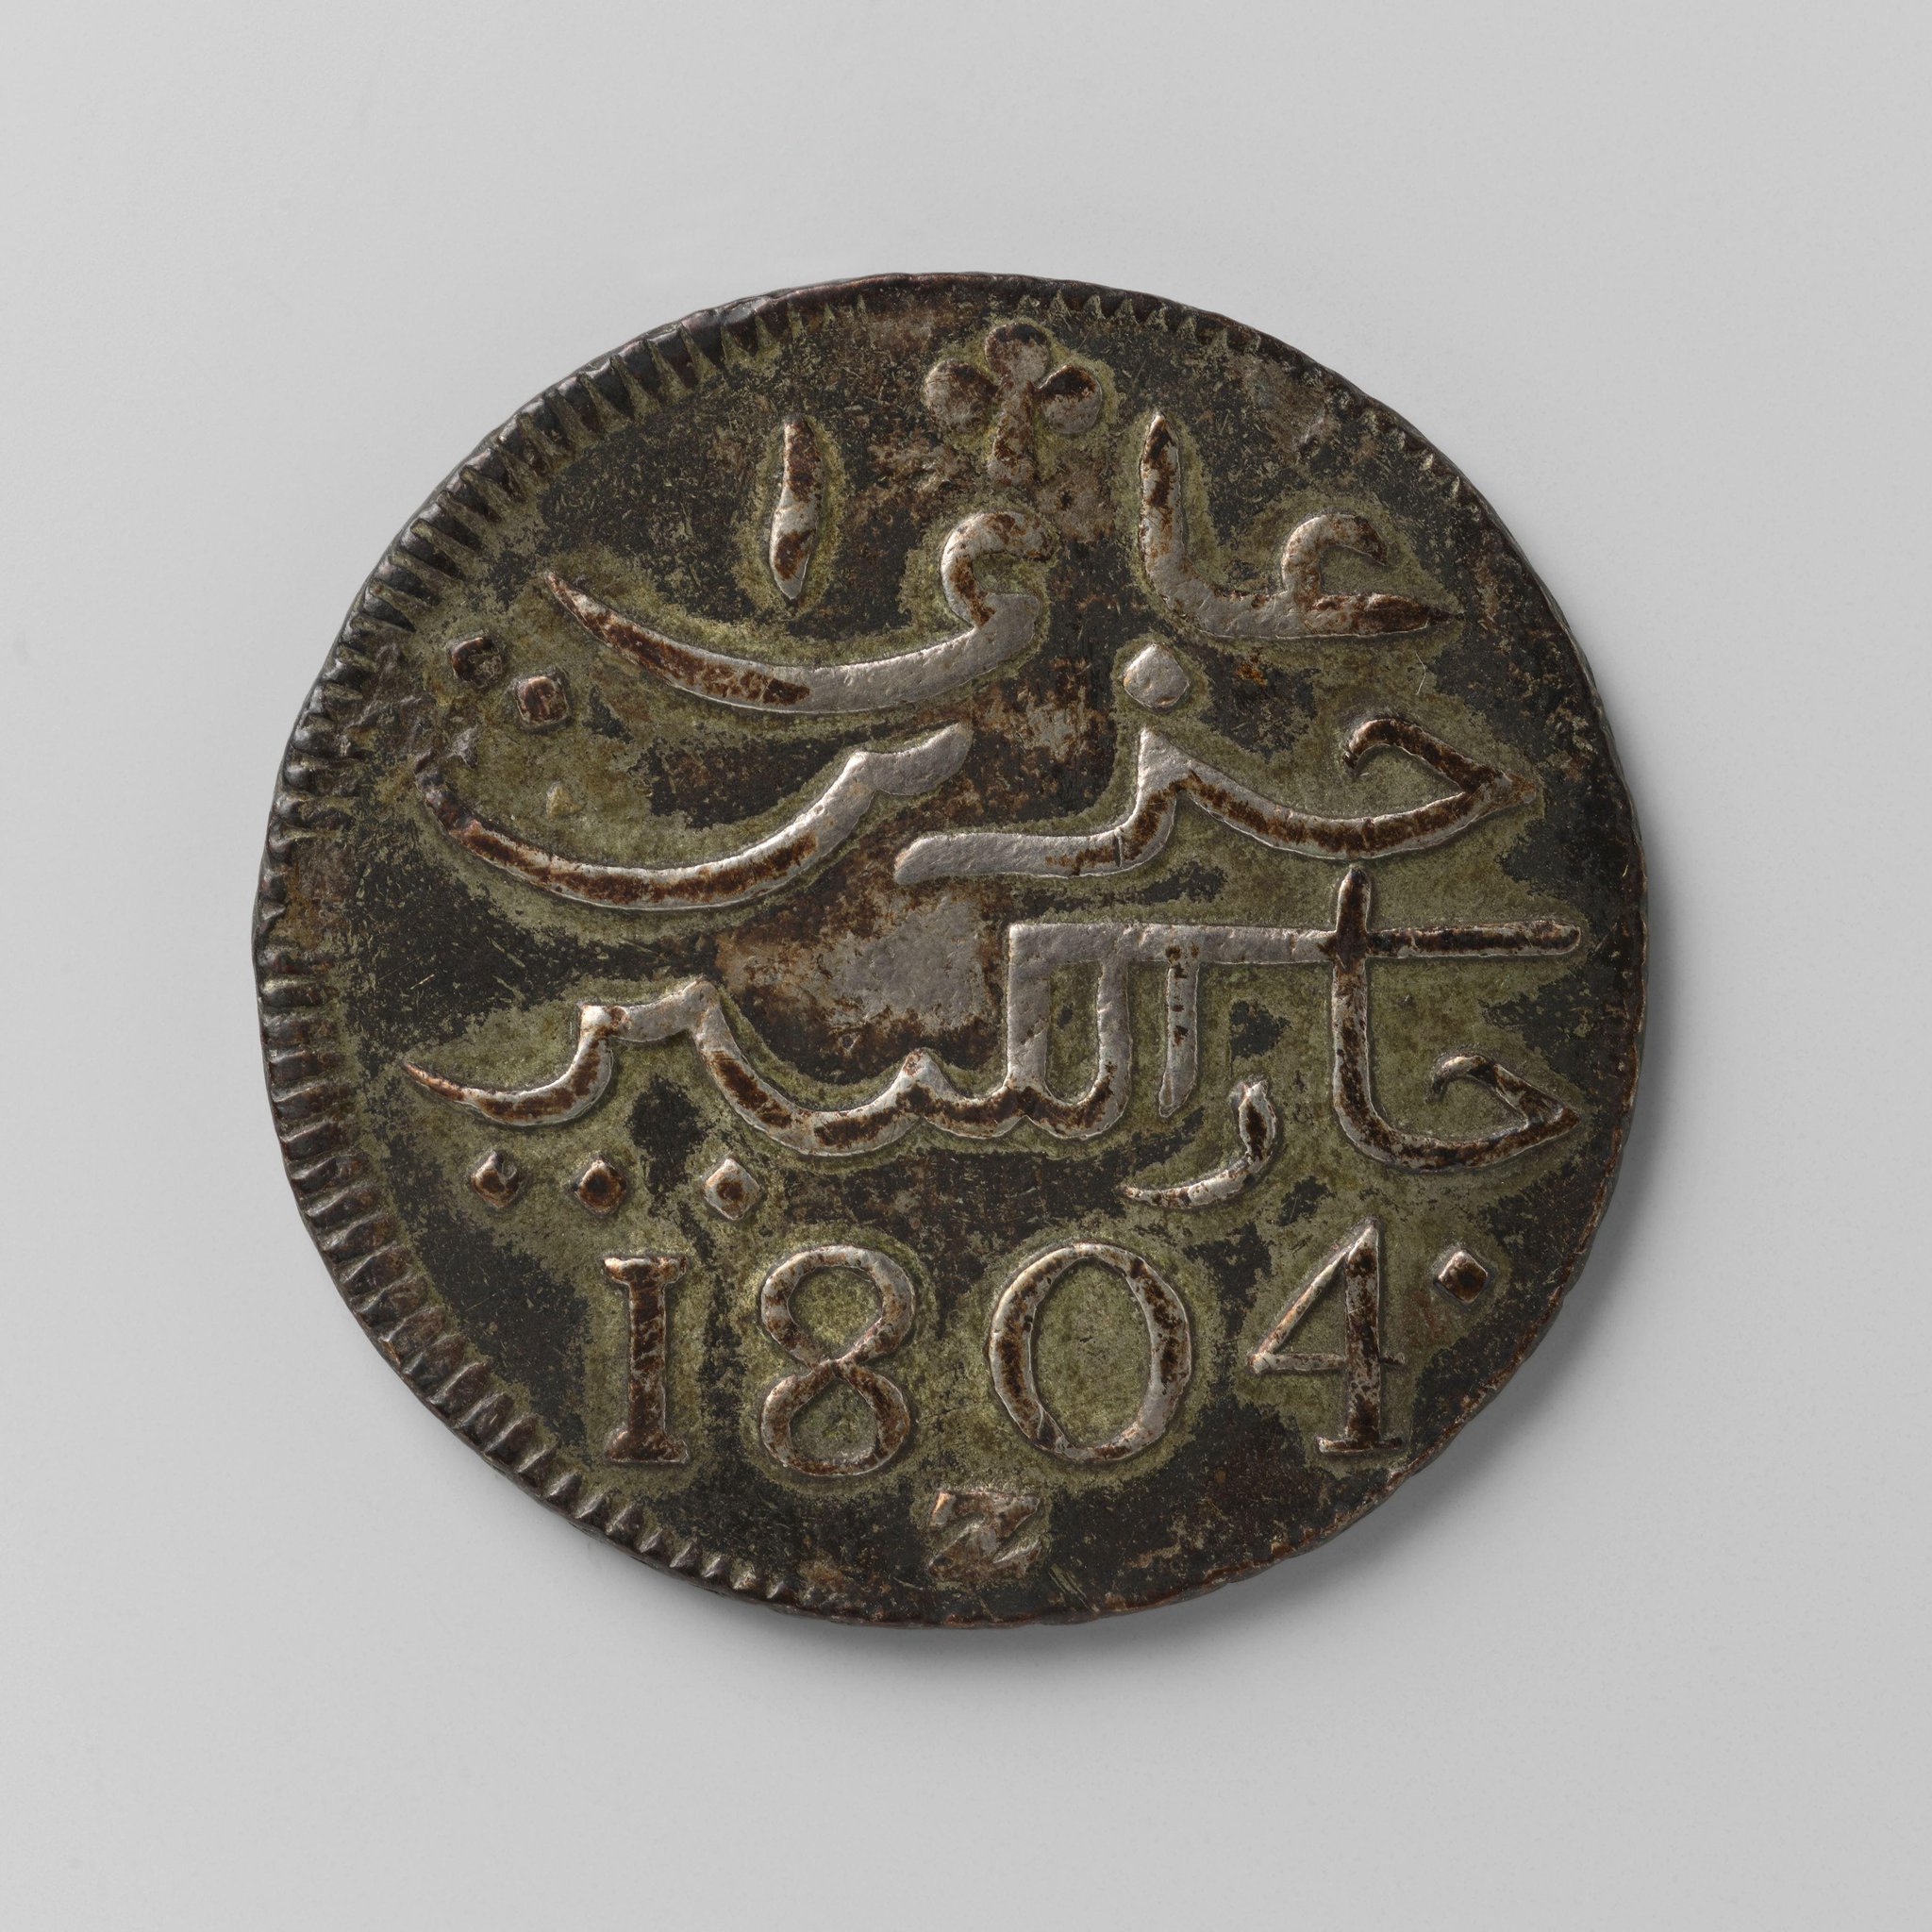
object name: coin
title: Zilveren ropij van Nederlands Indië uit Java, 1804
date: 1804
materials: silver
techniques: striking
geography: batavia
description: Zilveren munt. Voorzijde: drieregelig opschrift in Arabische letters. Daarboven muntteken en daaronder jaartal, waaronder muntmeesterteken Z [=muntmeester Zwekkert]. Keerzijde: vierregelig opschrift in Arabische letters. Kabelrand.